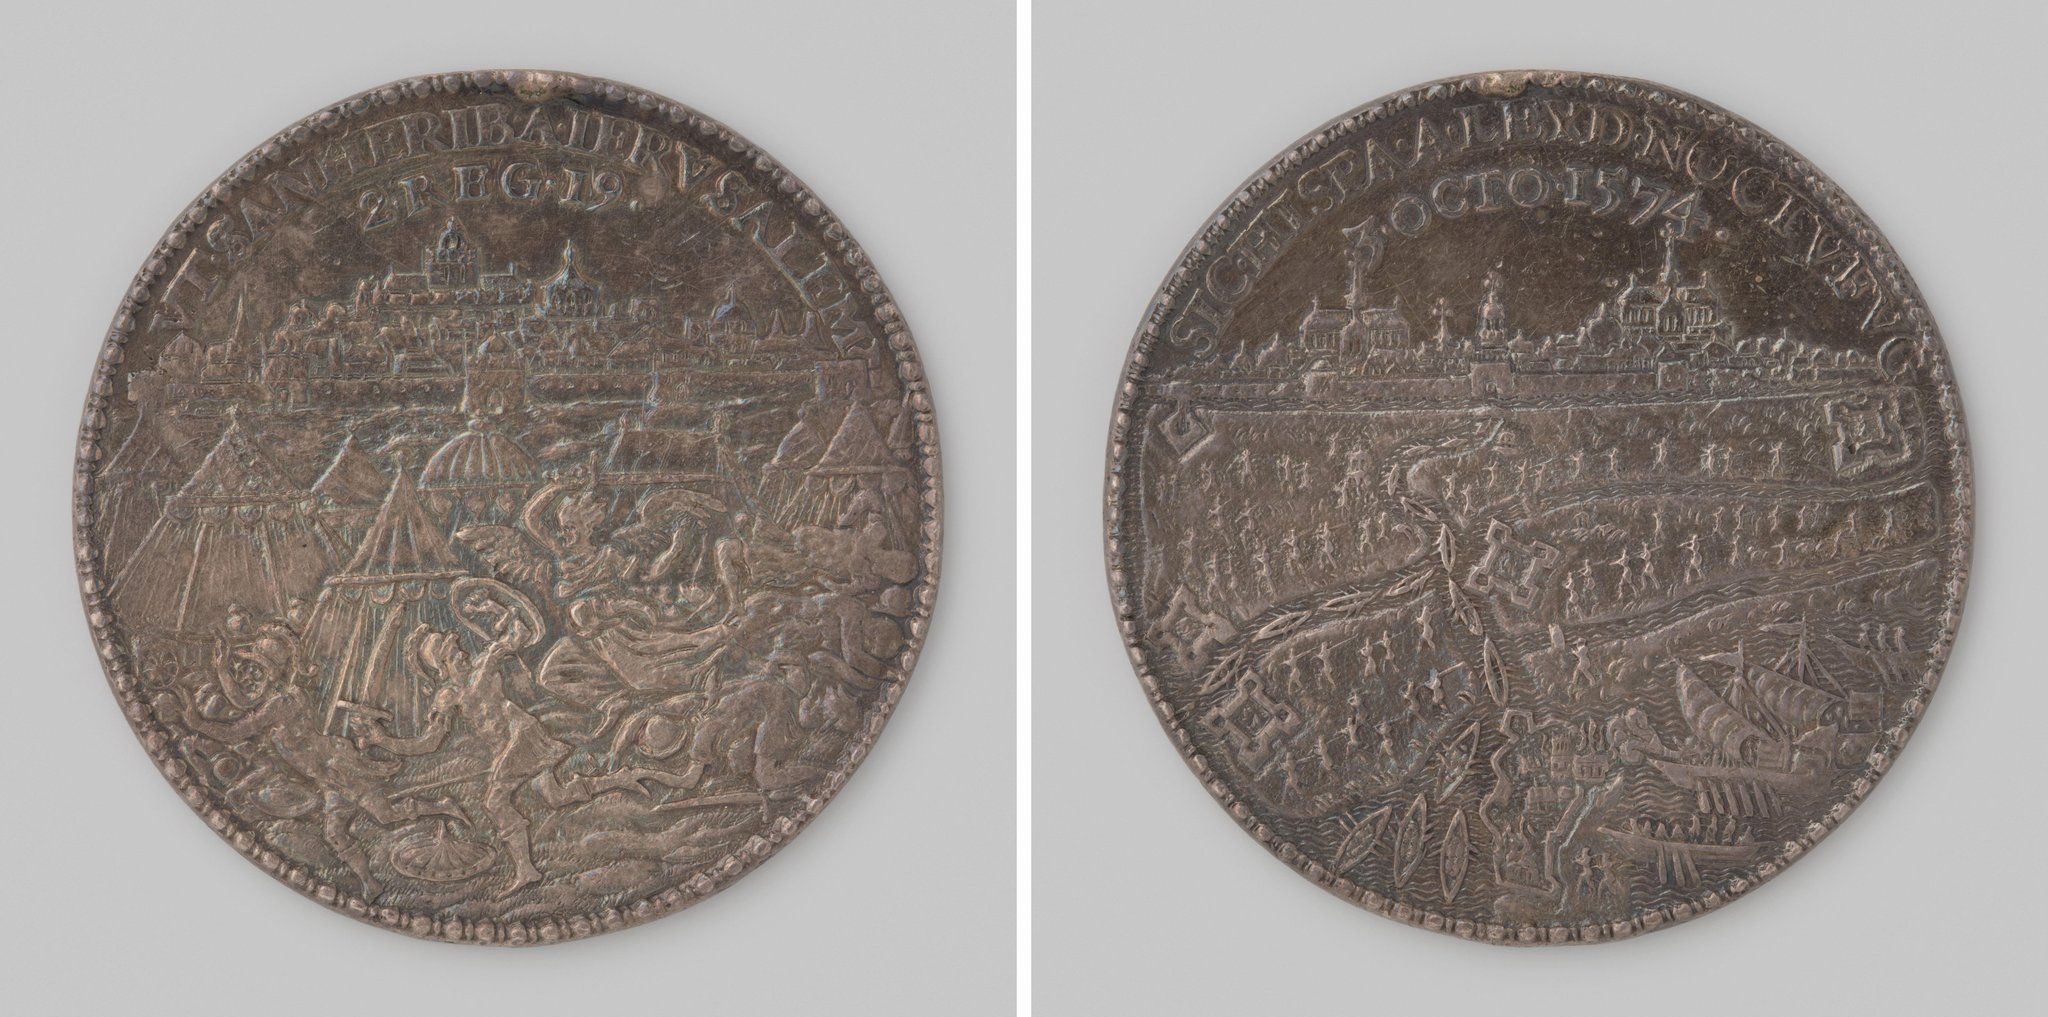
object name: history medal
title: Beleg van Leiden 1574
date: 1574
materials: silver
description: Zilveren penning, op de voorzijde het leger van Sanherib voor Jerusalem door een engel verdreven, met omschrift, op de keerzijde aanzicht en plattegrond van Leiden waar Spanjaarden hun schansen verlaten